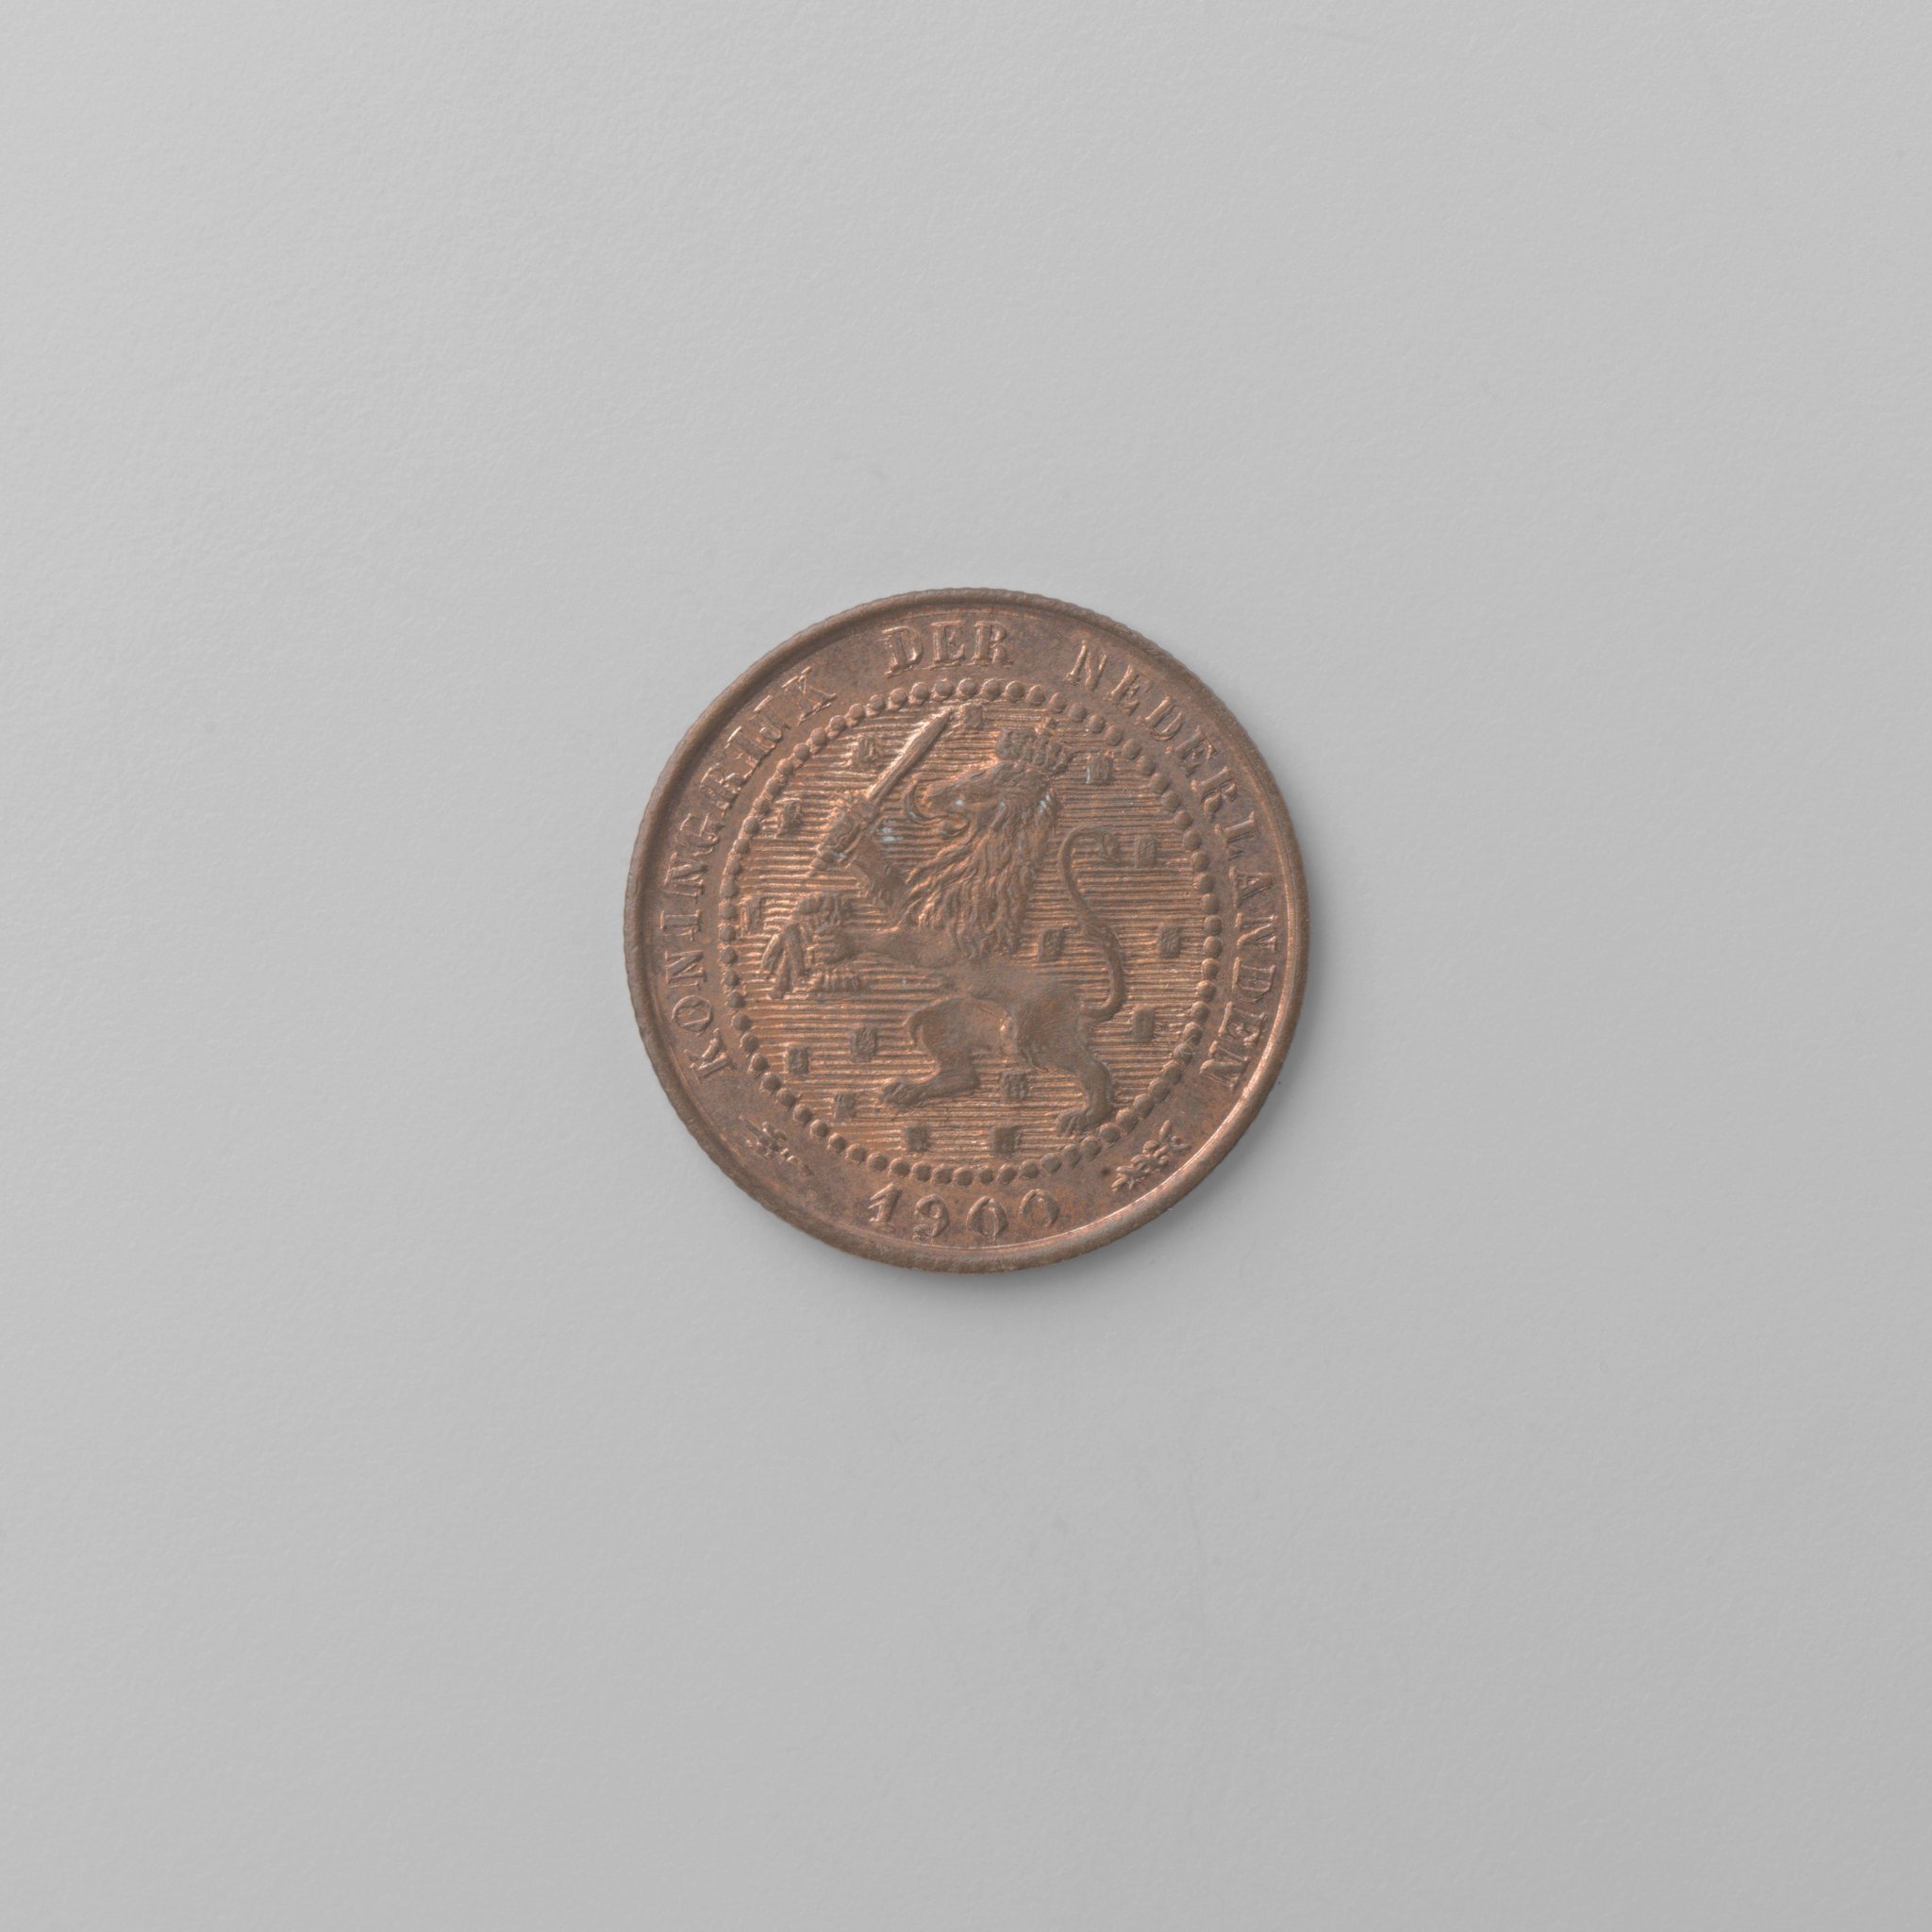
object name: coin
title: Nederlandse cent,1900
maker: wilhelmina of the netherlands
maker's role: print maker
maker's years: 1880-1962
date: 1900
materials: bronze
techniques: striking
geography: utrecht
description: Bronzen munt. Voorzijde: in een veld rijkswapen. Jaartal onderaan in omschrift. Keerzijde: binnen twee samengebonden oranjetakken waarde-aanduiding 1 cent. Kartelrand.